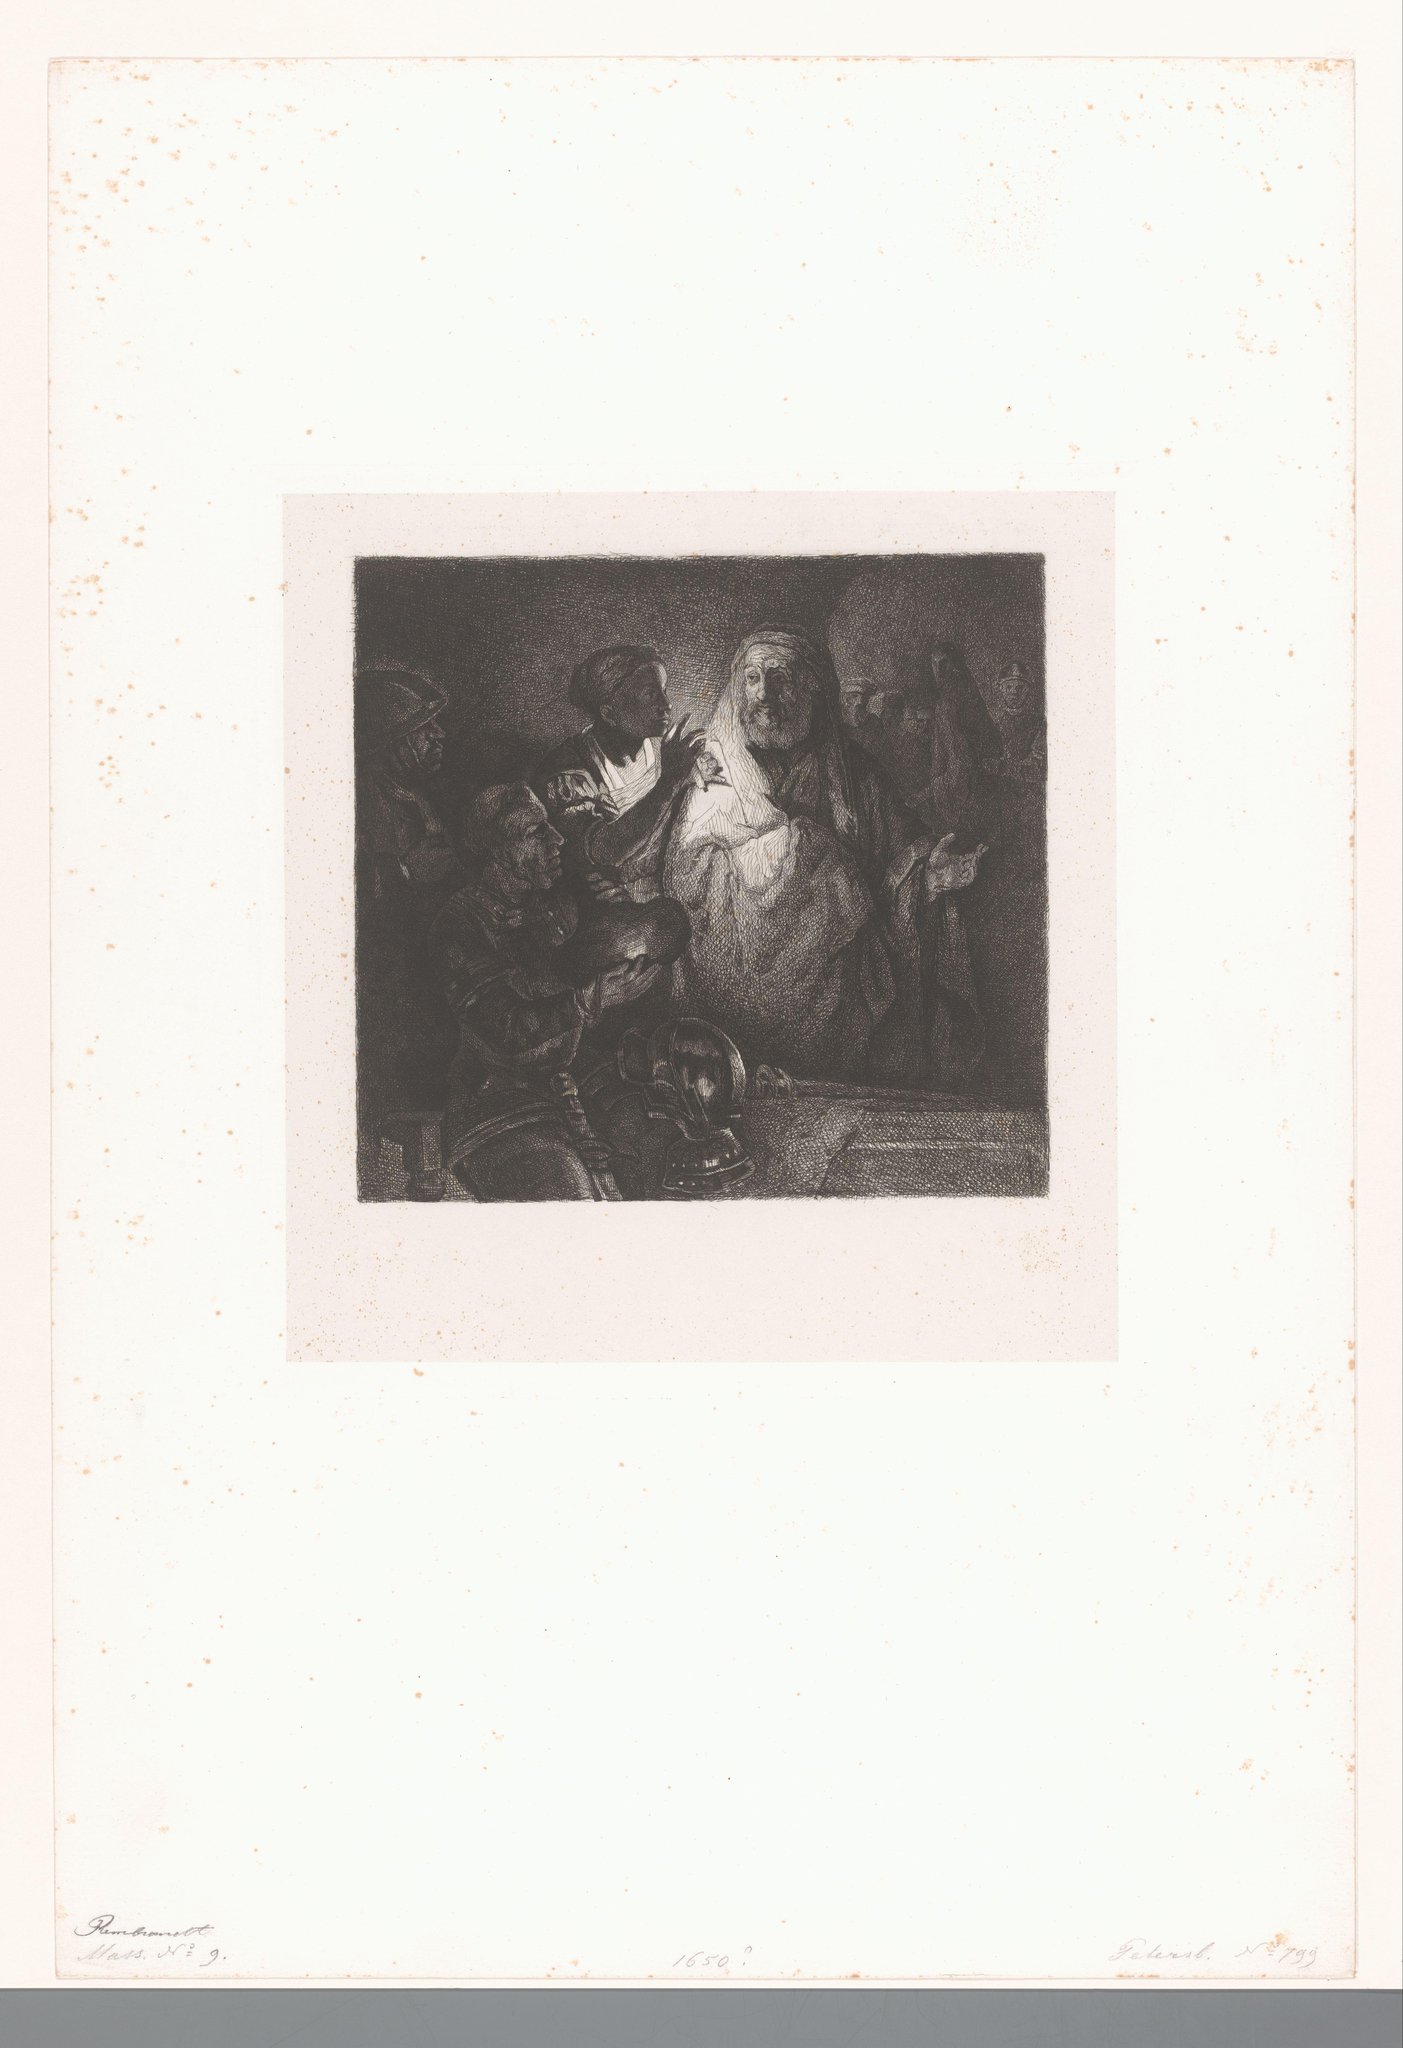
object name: print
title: Verloochening van Petrus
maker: nikolay semyonovich mosolov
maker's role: print maker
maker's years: 1847-1914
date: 1857-1914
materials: paper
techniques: drypoint, etching, intaglio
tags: peter denies christ, usually before a girl-servant and some soldiers, slavery; serfs and enslaved persons